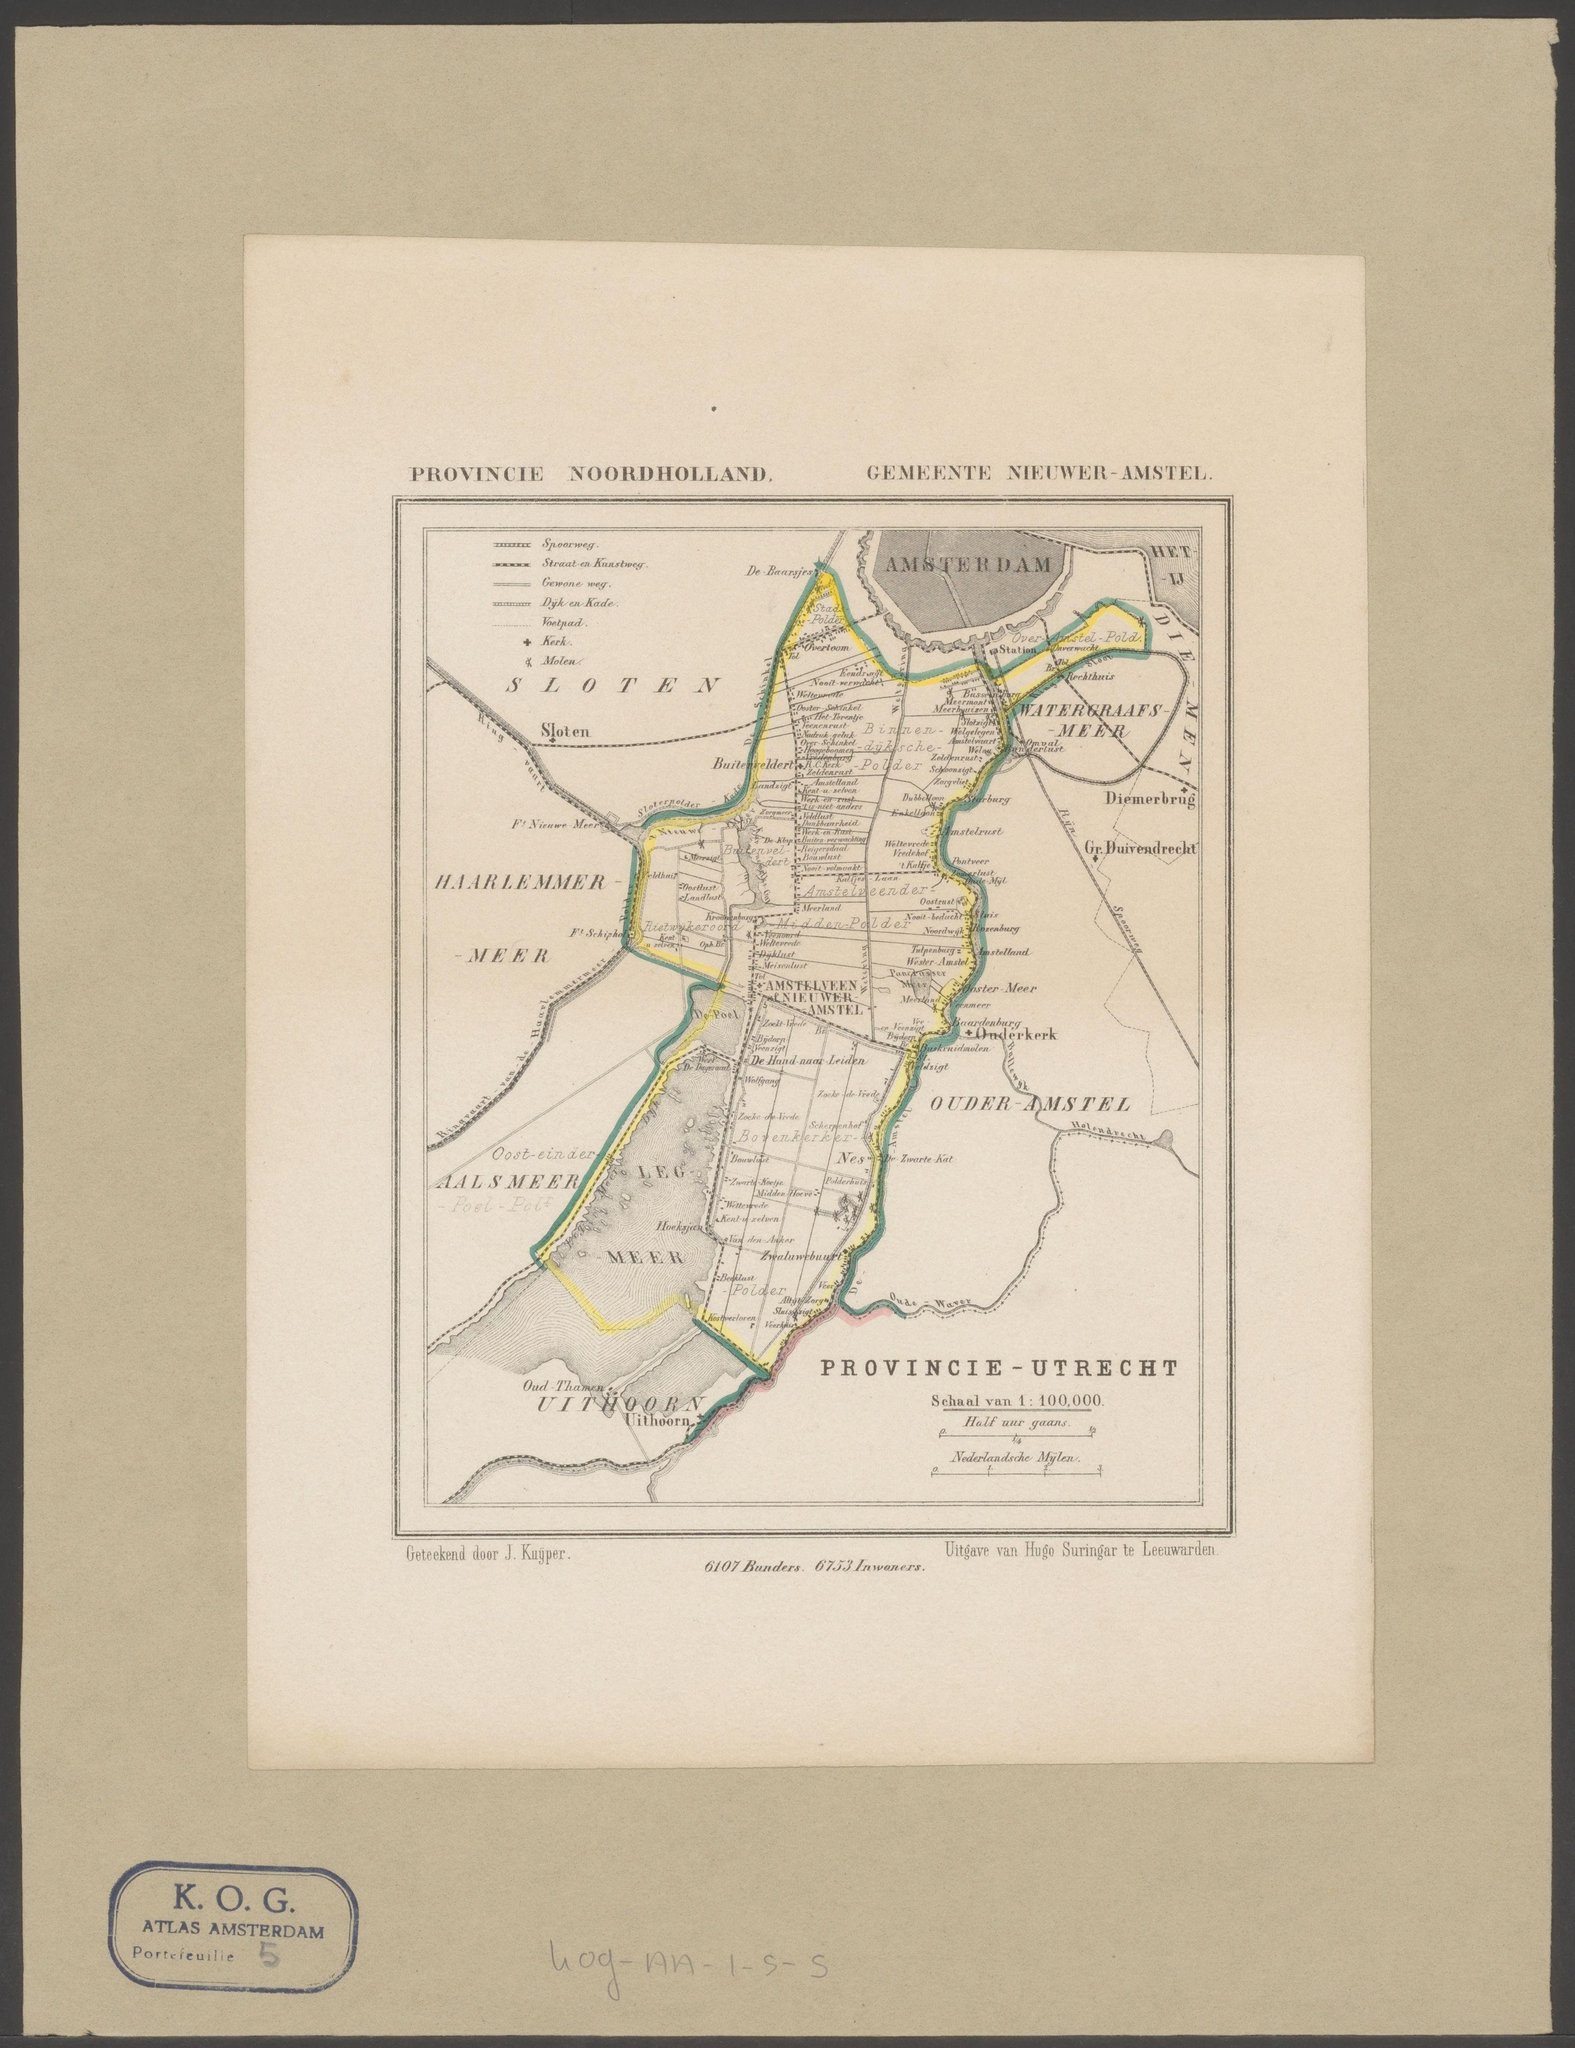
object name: photomechanical print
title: Plattegrond van de gemeente Nieuwer-Amstel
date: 1844-1908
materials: paper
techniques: hand coloring, line block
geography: leeuwarden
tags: maps of separate countries or regions, city-view in general; 'veduta'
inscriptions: collector's mark: ‘5’ Lugt 1641b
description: Onderwerpsrubriek binnen de Atlas Amsterdam: Amstel buiten de stad, Amsteldijk.